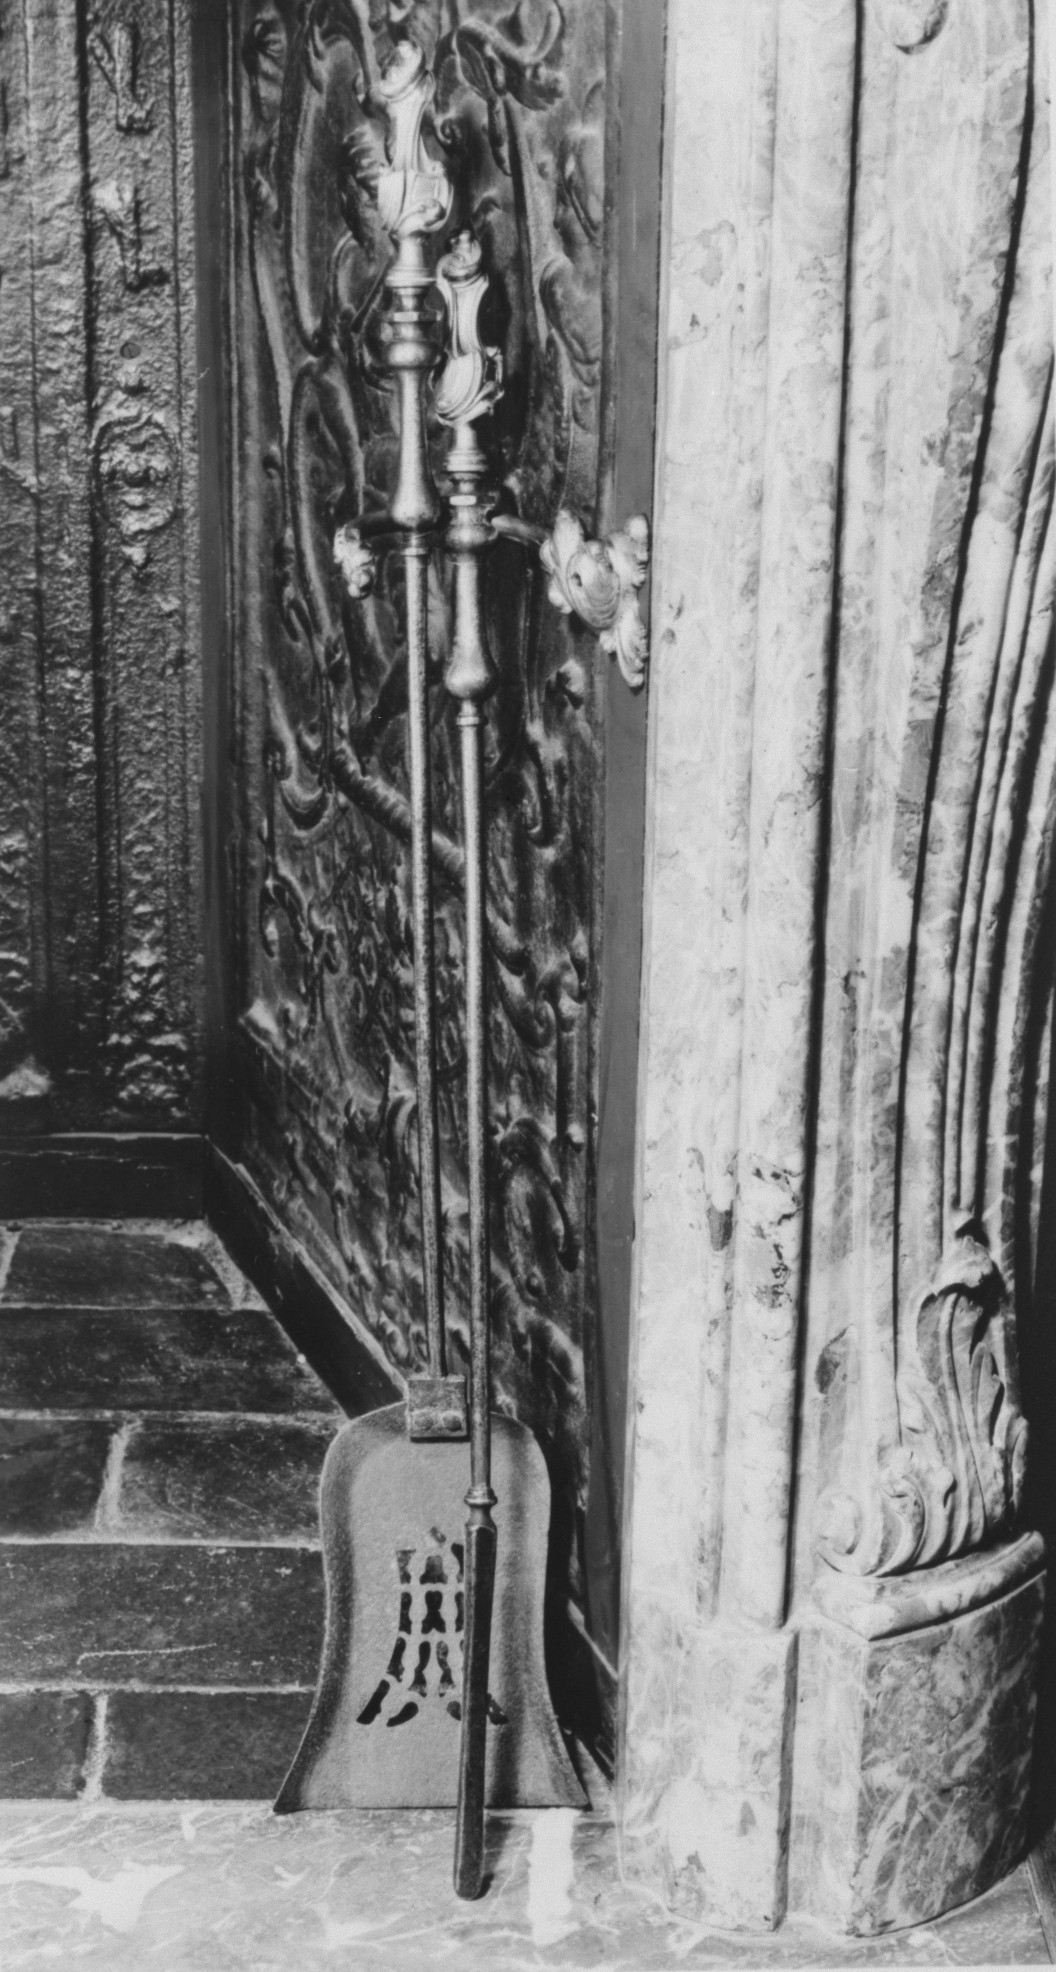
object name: shovel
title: Shovel (part of a set)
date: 1730-1760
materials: gilt bronze, steel